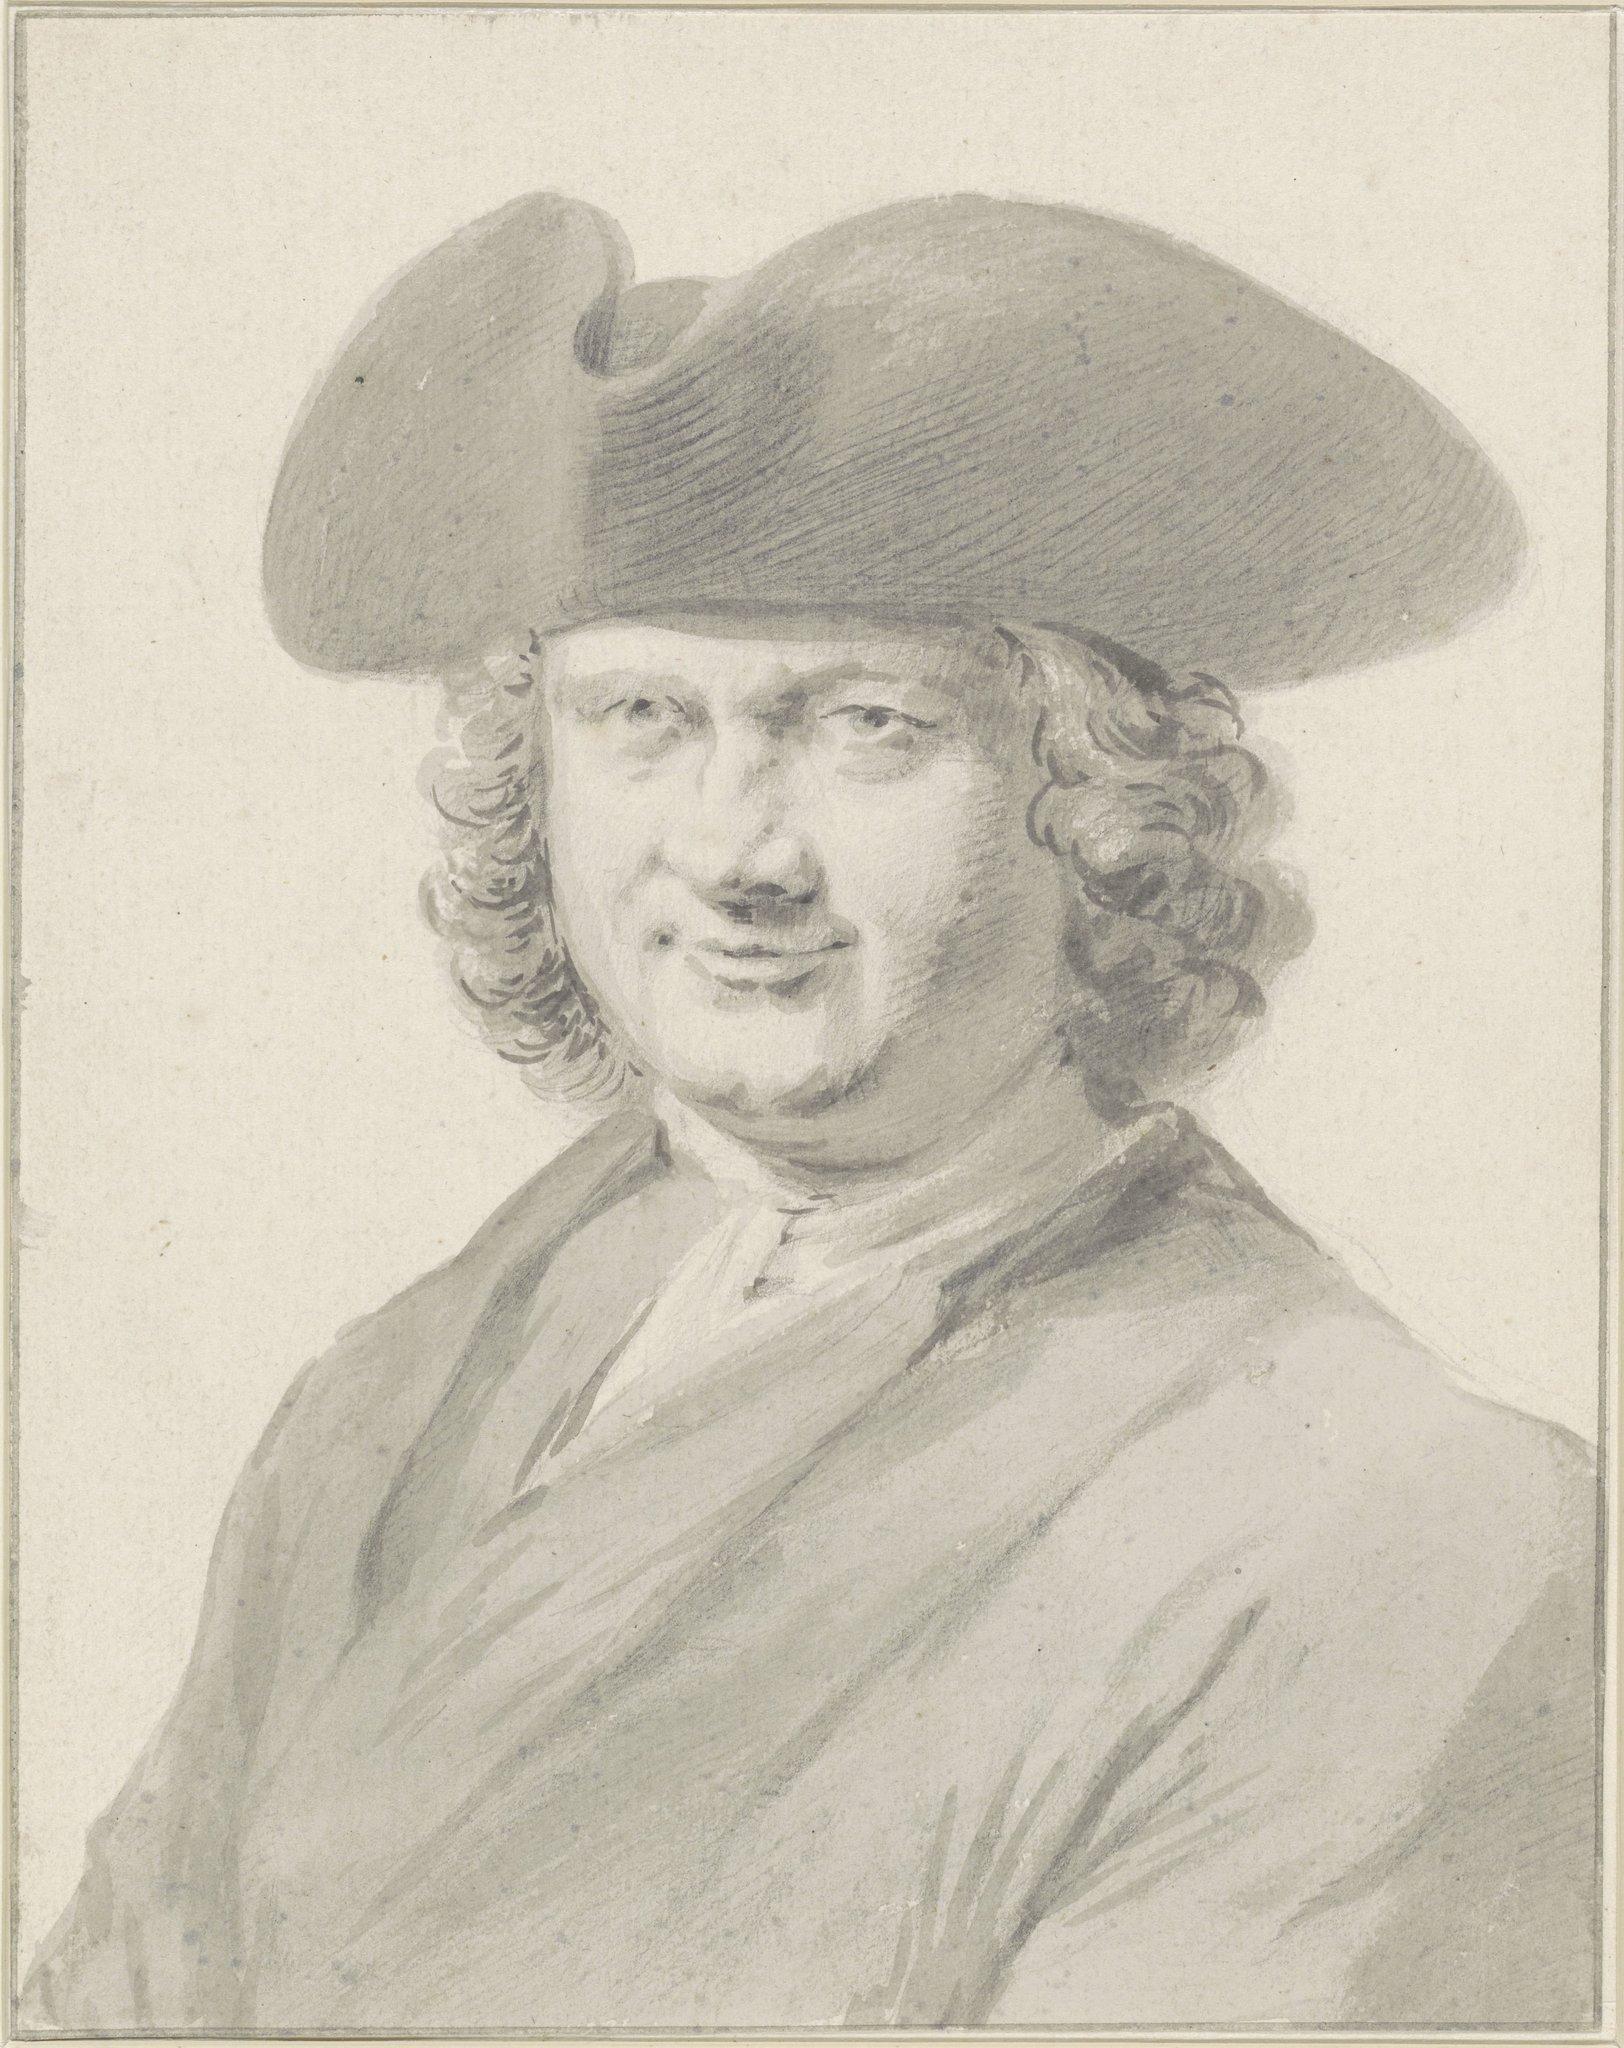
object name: drawing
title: Zelfportret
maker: cornelis pronk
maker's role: draughtsman, painter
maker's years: 1691-1759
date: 1735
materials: paper, pencil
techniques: brush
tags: amsterdam, painter, draughtsman, cornelis pronk, historical persons, portrait, self-portrait of artist